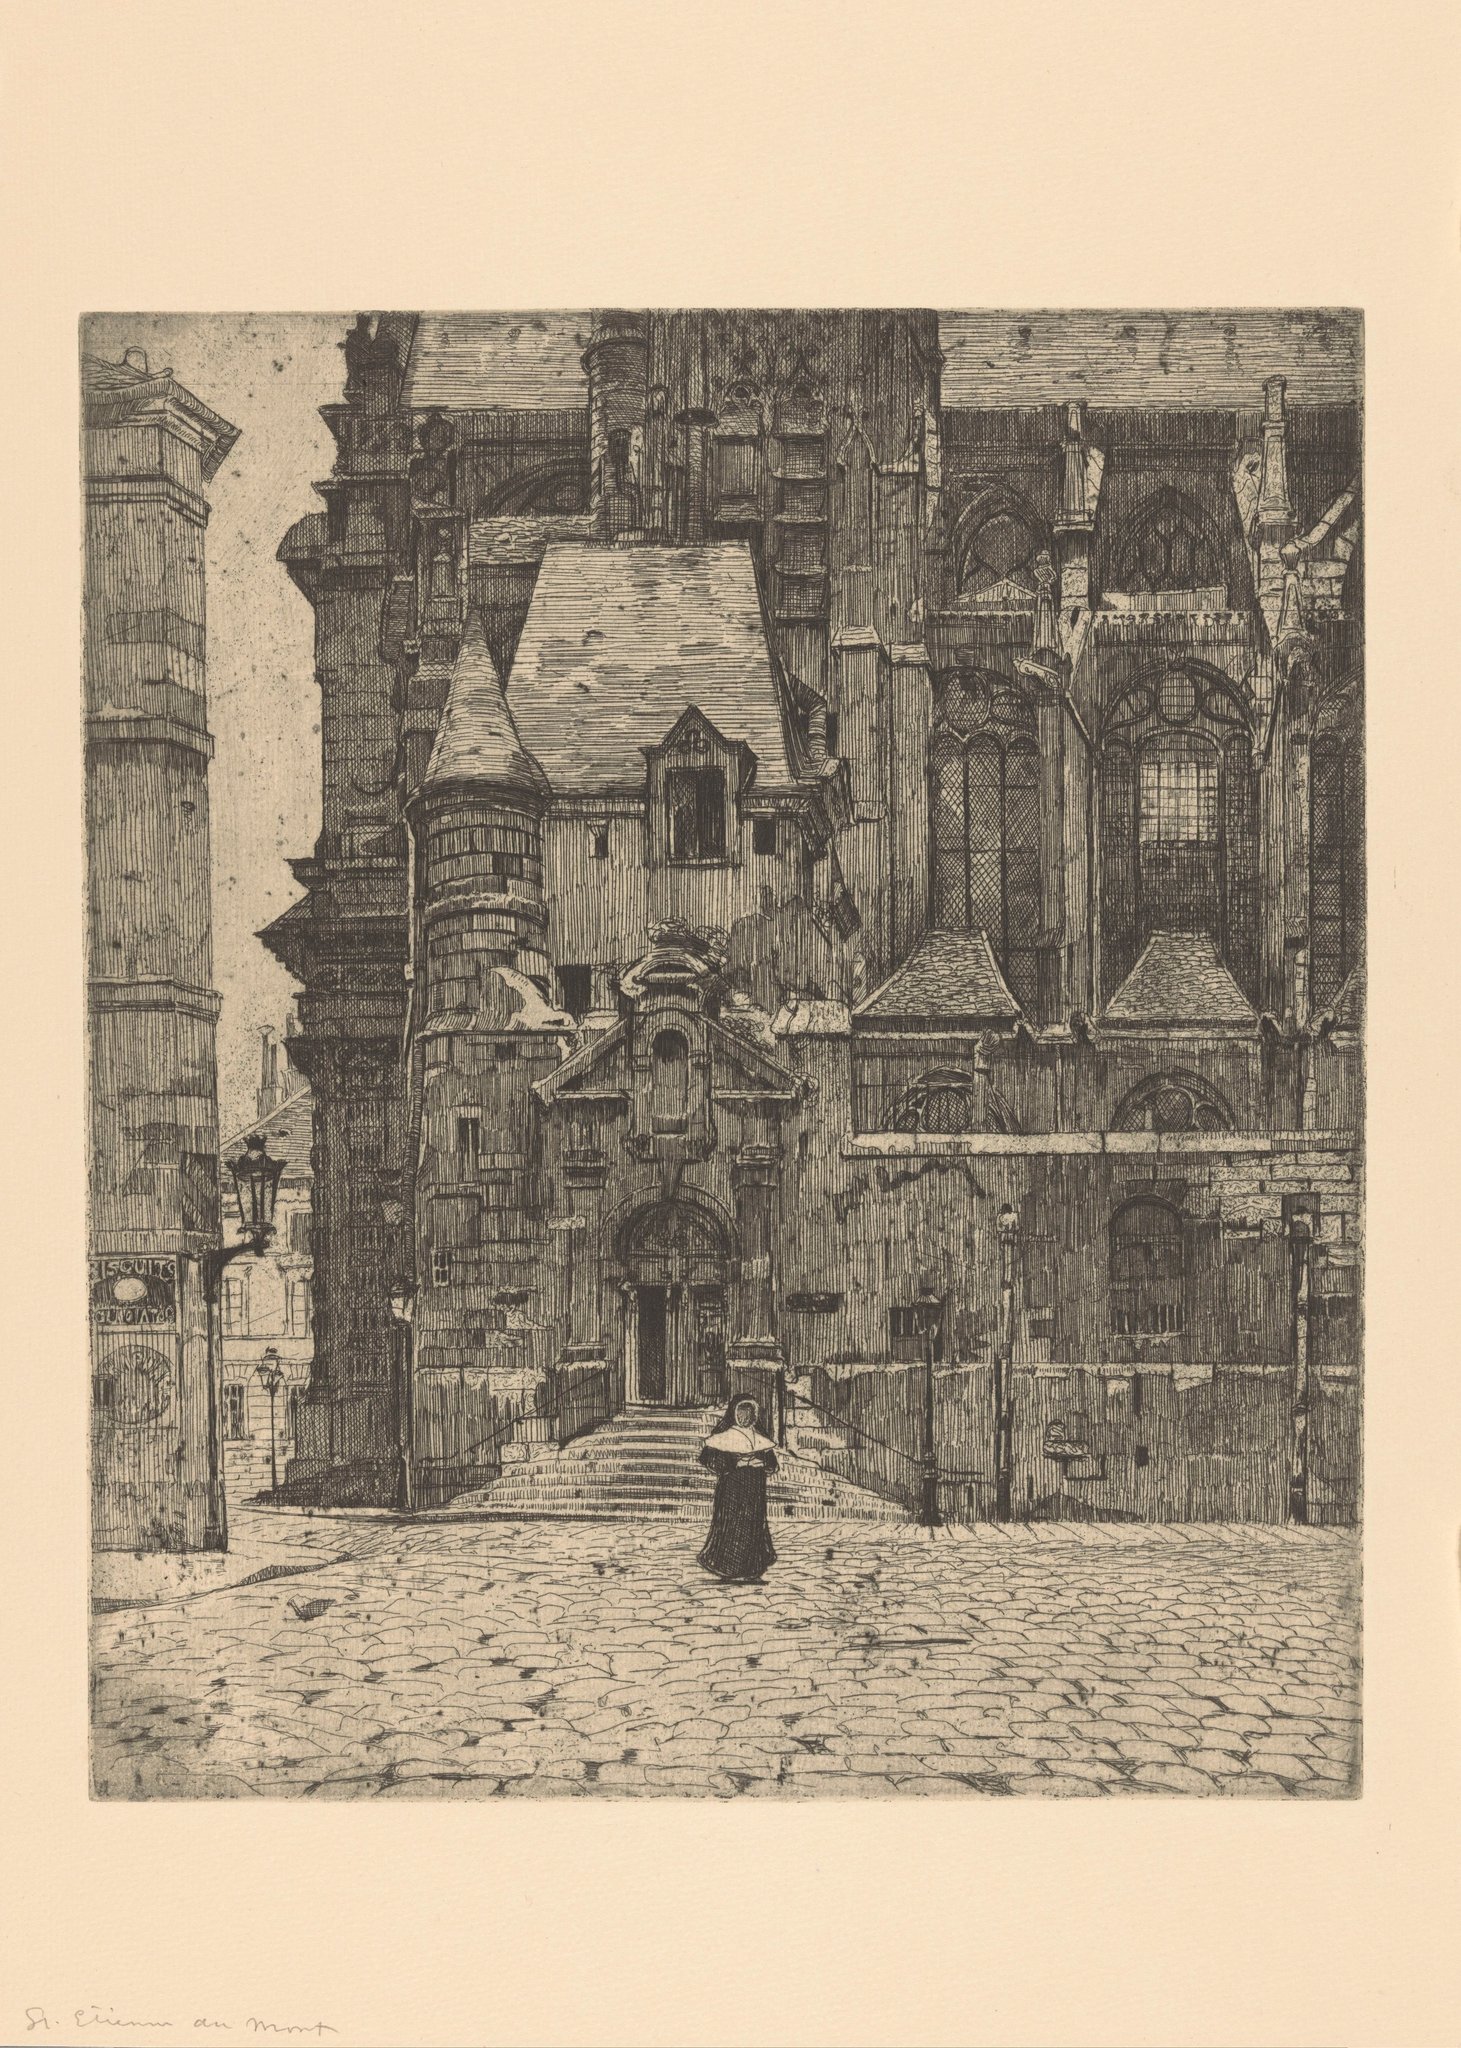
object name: print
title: Saint-Étienne-du-Mont in Parijs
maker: martin monnickendam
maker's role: draughtsman, painter, print maker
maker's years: 1874-1943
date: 1896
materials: paper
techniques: etching, intaglio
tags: nun(s), church (exterior)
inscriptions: collector's mark: Lugt 2228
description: Op het plein voor de kerk loopt een non.